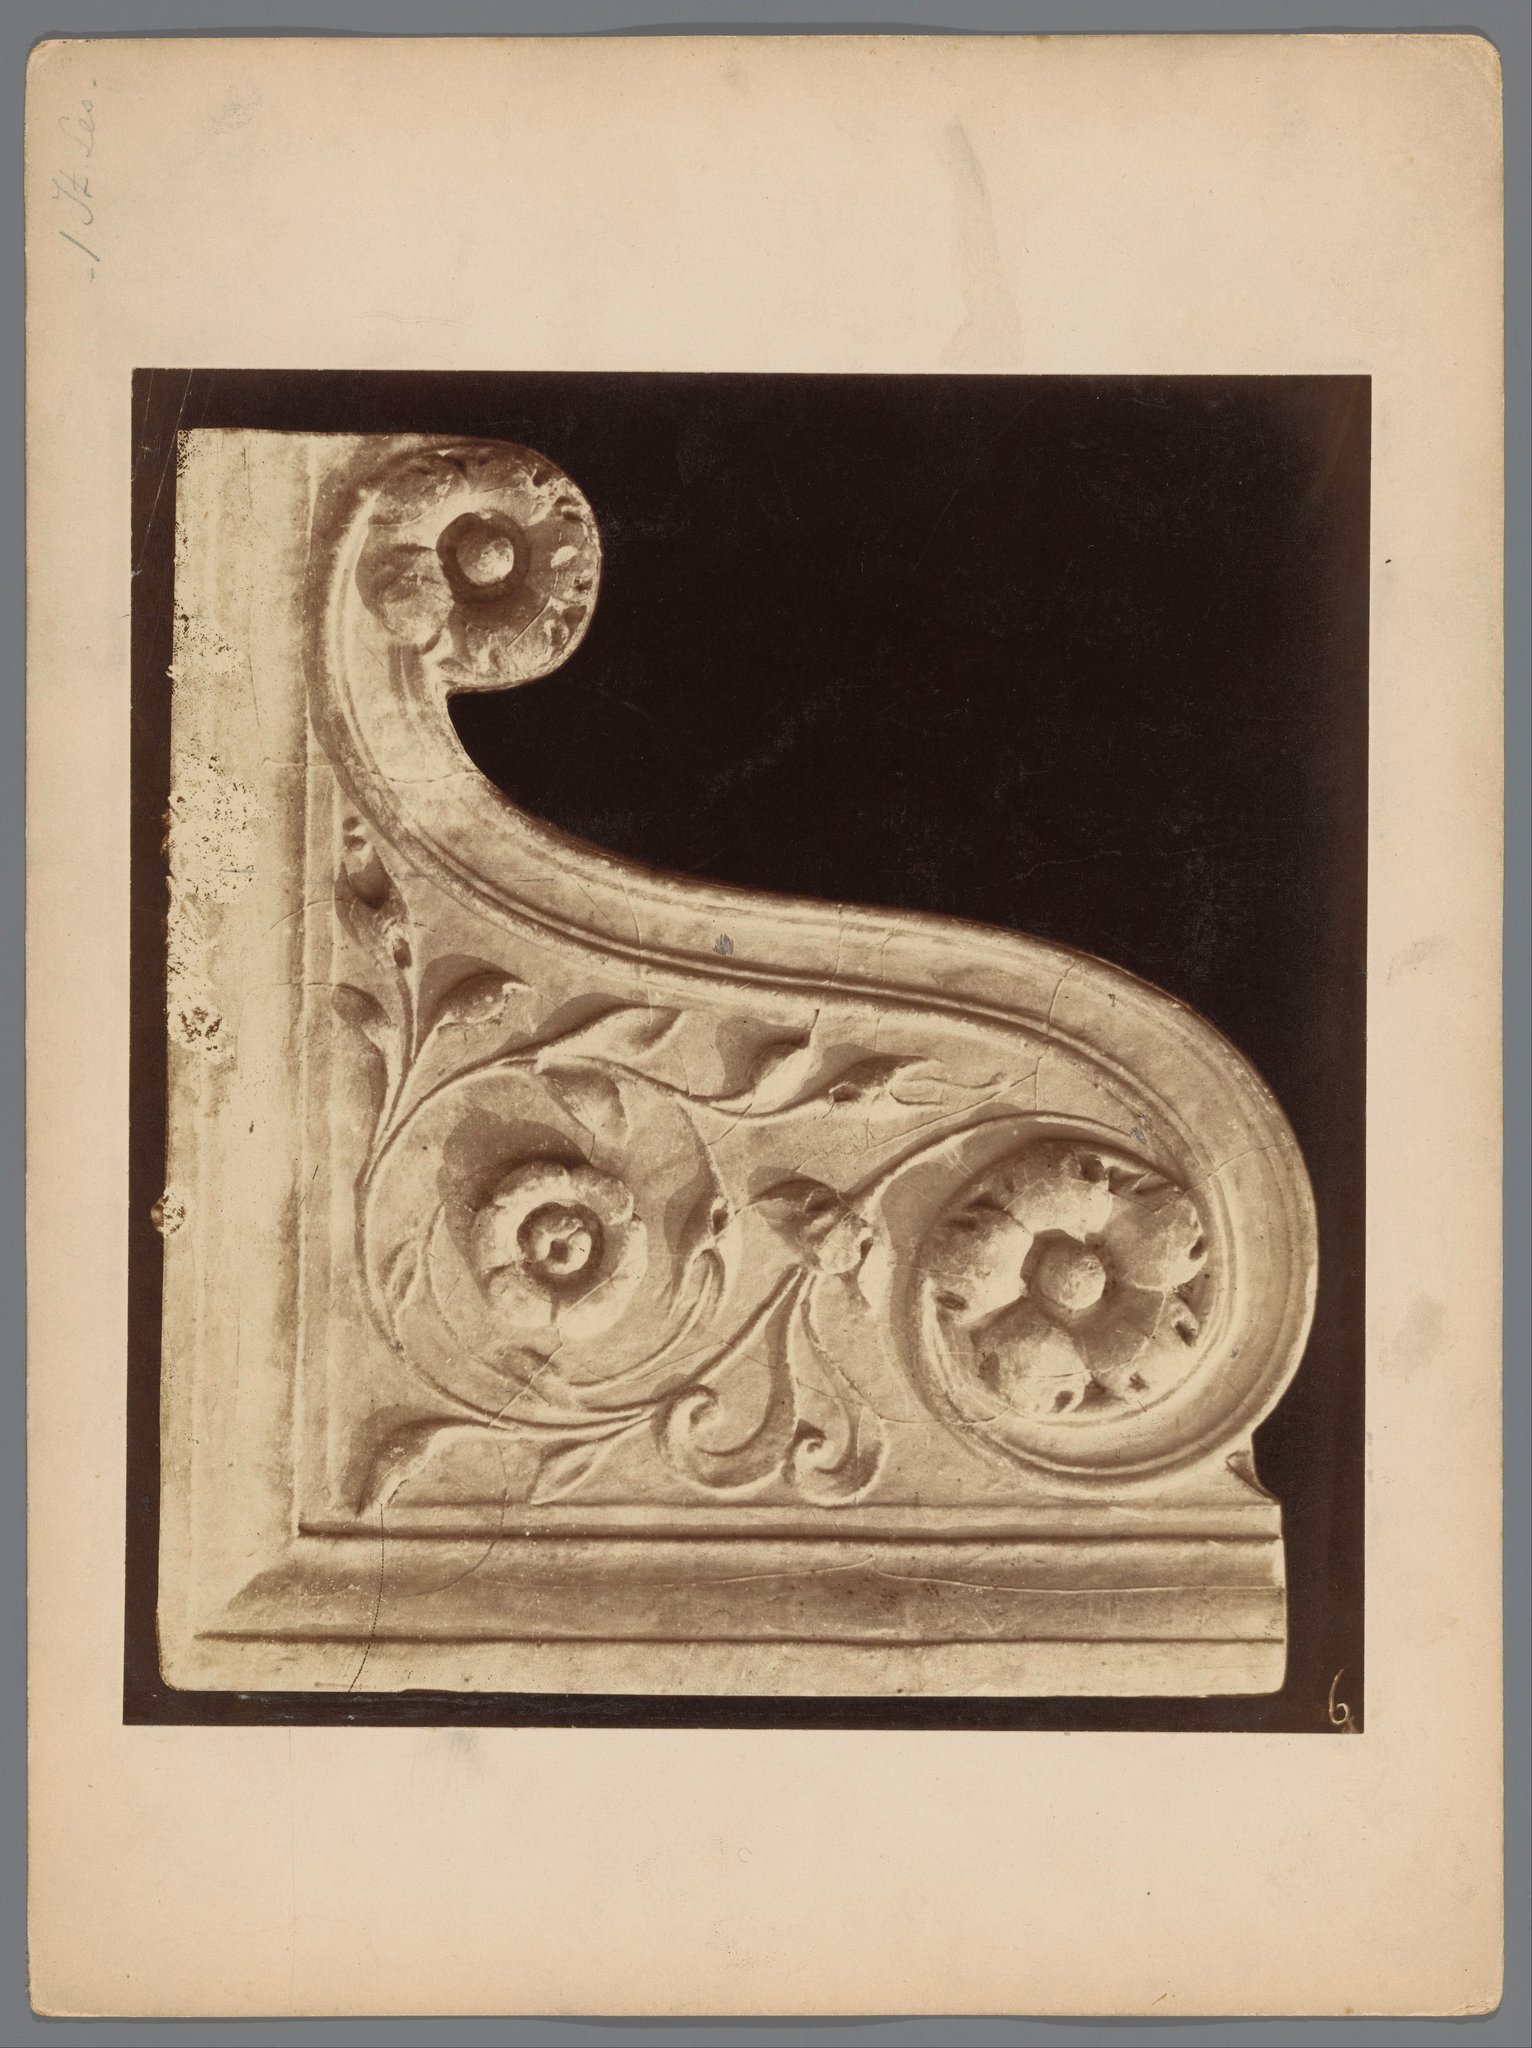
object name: photograph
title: Console in de vorm van een voluut met een bloemmotief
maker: Anonymous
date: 1875-1900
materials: cardboard, photographic support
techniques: albumen print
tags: other architectural details, flowers ~ ornament, sculpture (+ relief ~ sculpture)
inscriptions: inscription: ‘1 It. Les.’, number: ‘6’, collector's mark: Lugt 3937